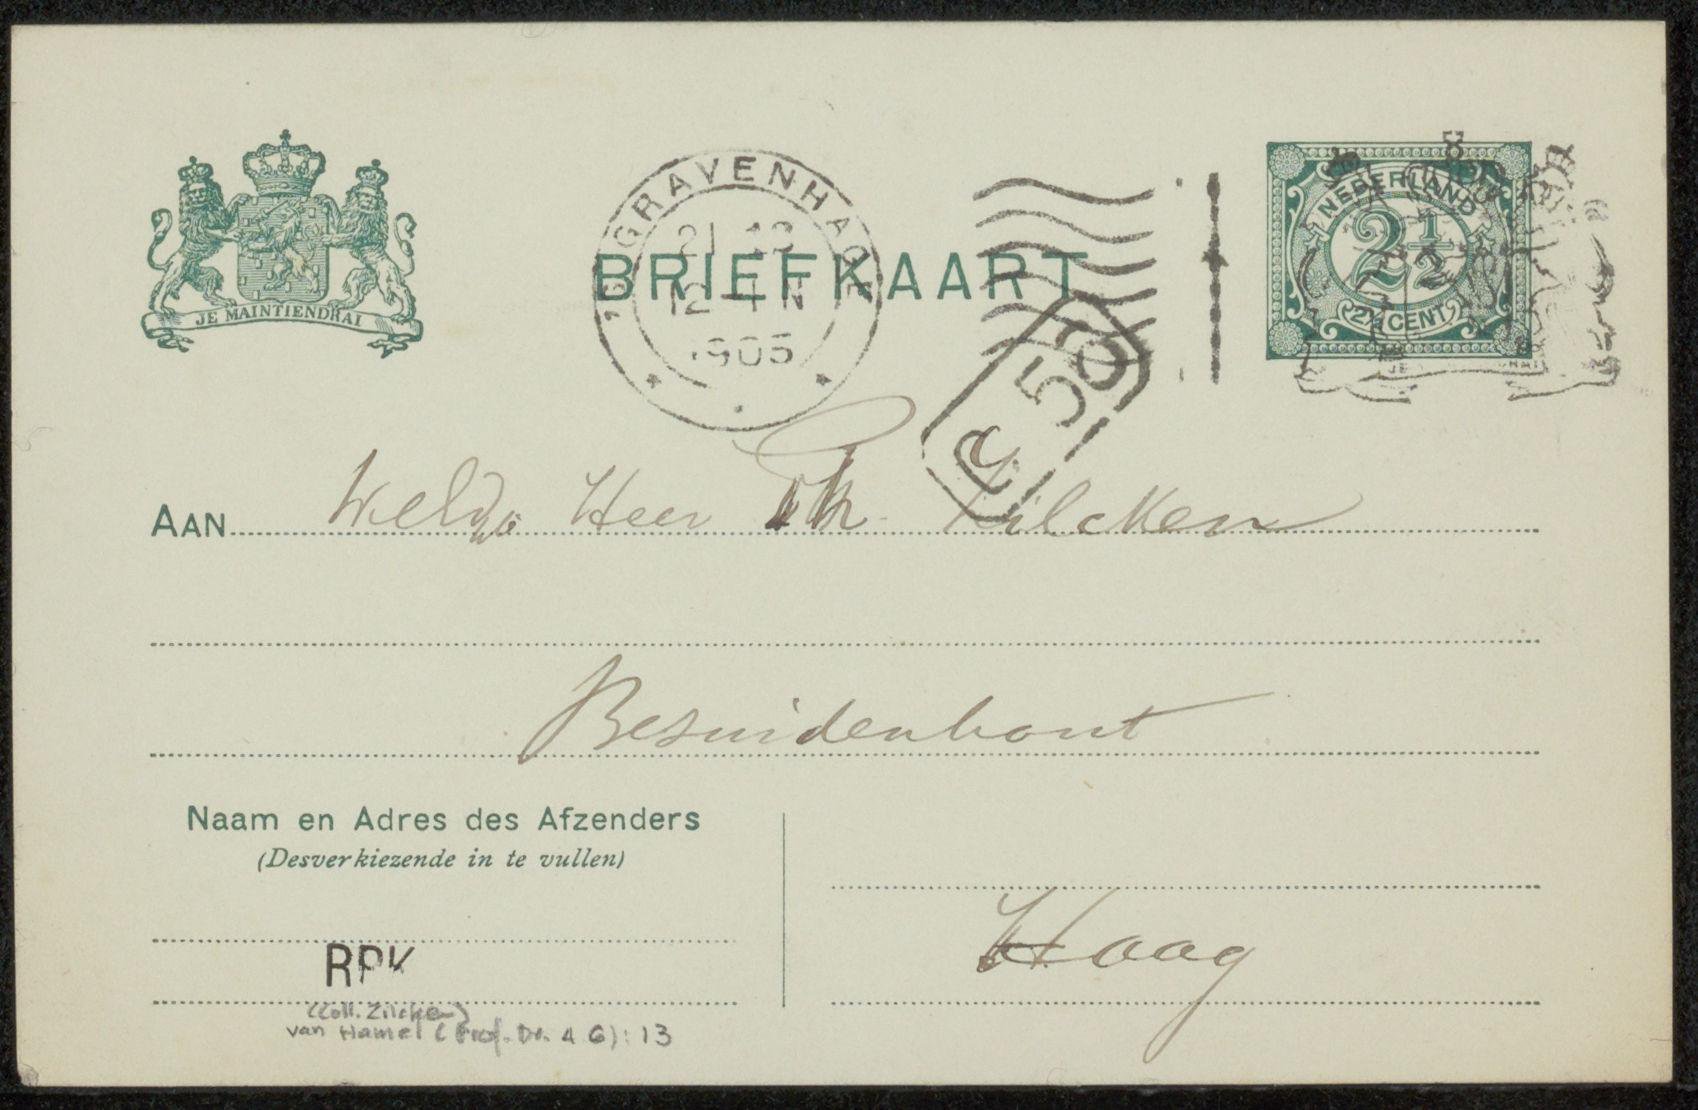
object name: postcard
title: Briefkaart aan Philip Zilcken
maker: antonius gerardus van hamel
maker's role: hoogleraar, theoloog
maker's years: 1842-1907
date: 1905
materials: cardboard, ink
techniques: pen, writing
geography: the hague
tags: maurice pernot, the hague, painter, draughtsman, philip zilcken, rotterdam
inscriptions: collector's mark: ‘RPK’